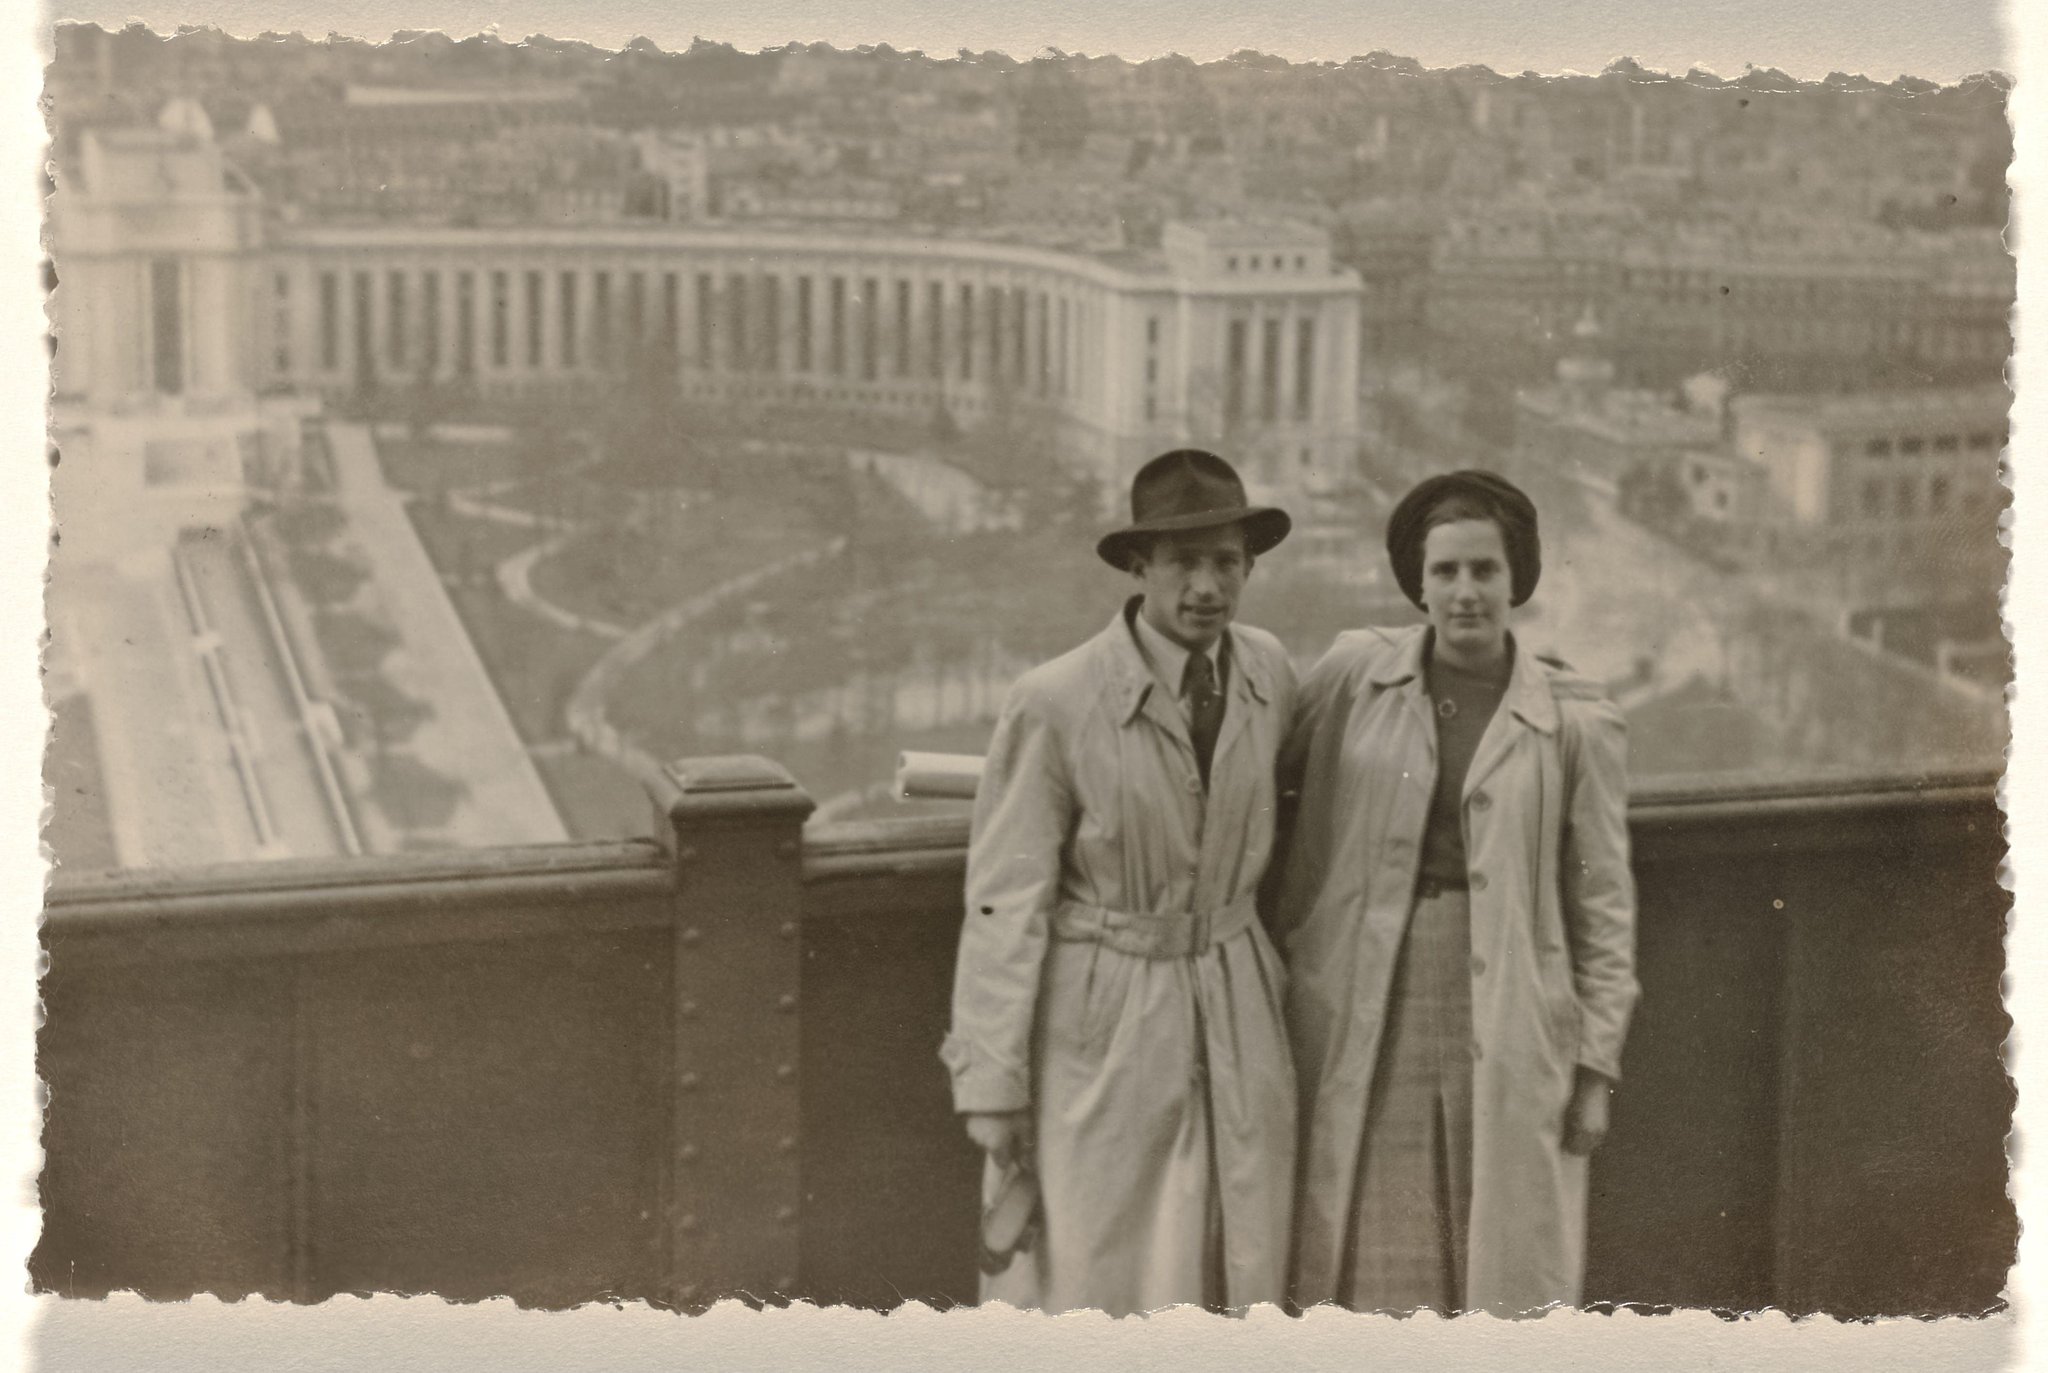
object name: photograph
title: Isabel Wachenheimer in lange jas en Leo Blumensohn in lange jas en gleufhoed, op de Eiffeltoren, 1945-1949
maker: Anonymous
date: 1945-1949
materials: photographic support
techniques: gelatin silver print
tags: leiden, isabel wachenheimer-elon, paris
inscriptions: inscription: ‘studio de la tour eiffel paris’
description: Isabel Wachenheimer in lange jas en Leo Blumensohn in lange jas en gleufhoed, op de Eiffeltoren.